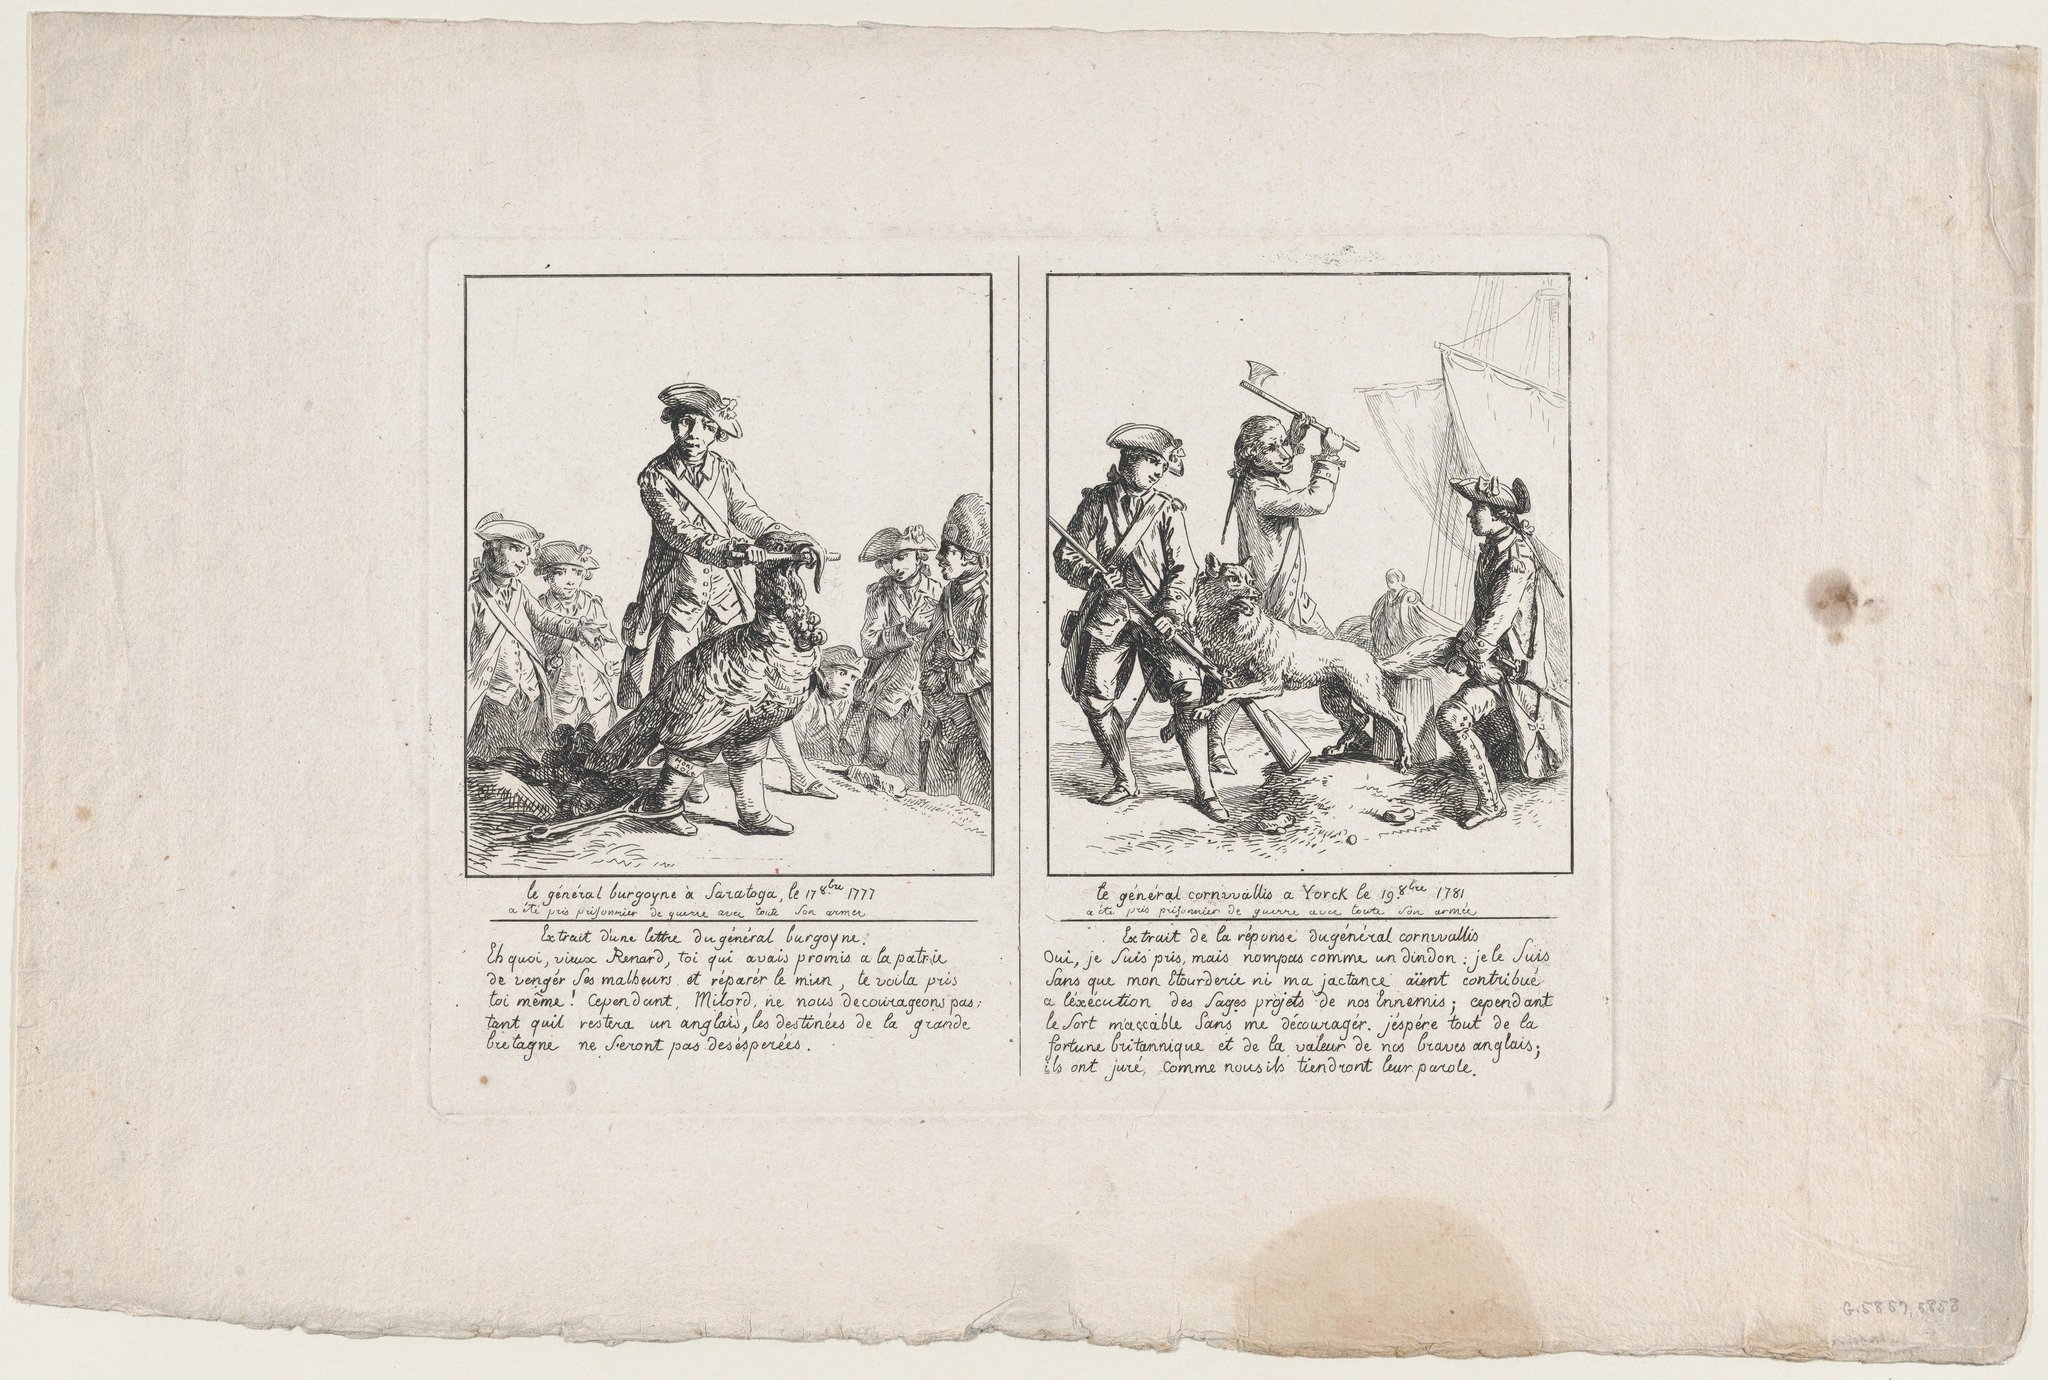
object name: print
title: Le Général Burgoyne à Saratoga, le 17 Octobre, 1777; and Le Général Cornwallis à Yorck, le 19 Octobre, 1781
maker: anonymous, french, 18th century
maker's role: artist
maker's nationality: french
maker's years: 1700-1800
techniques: etching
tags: satire,american revolution,men,turkeys,foxes,politics